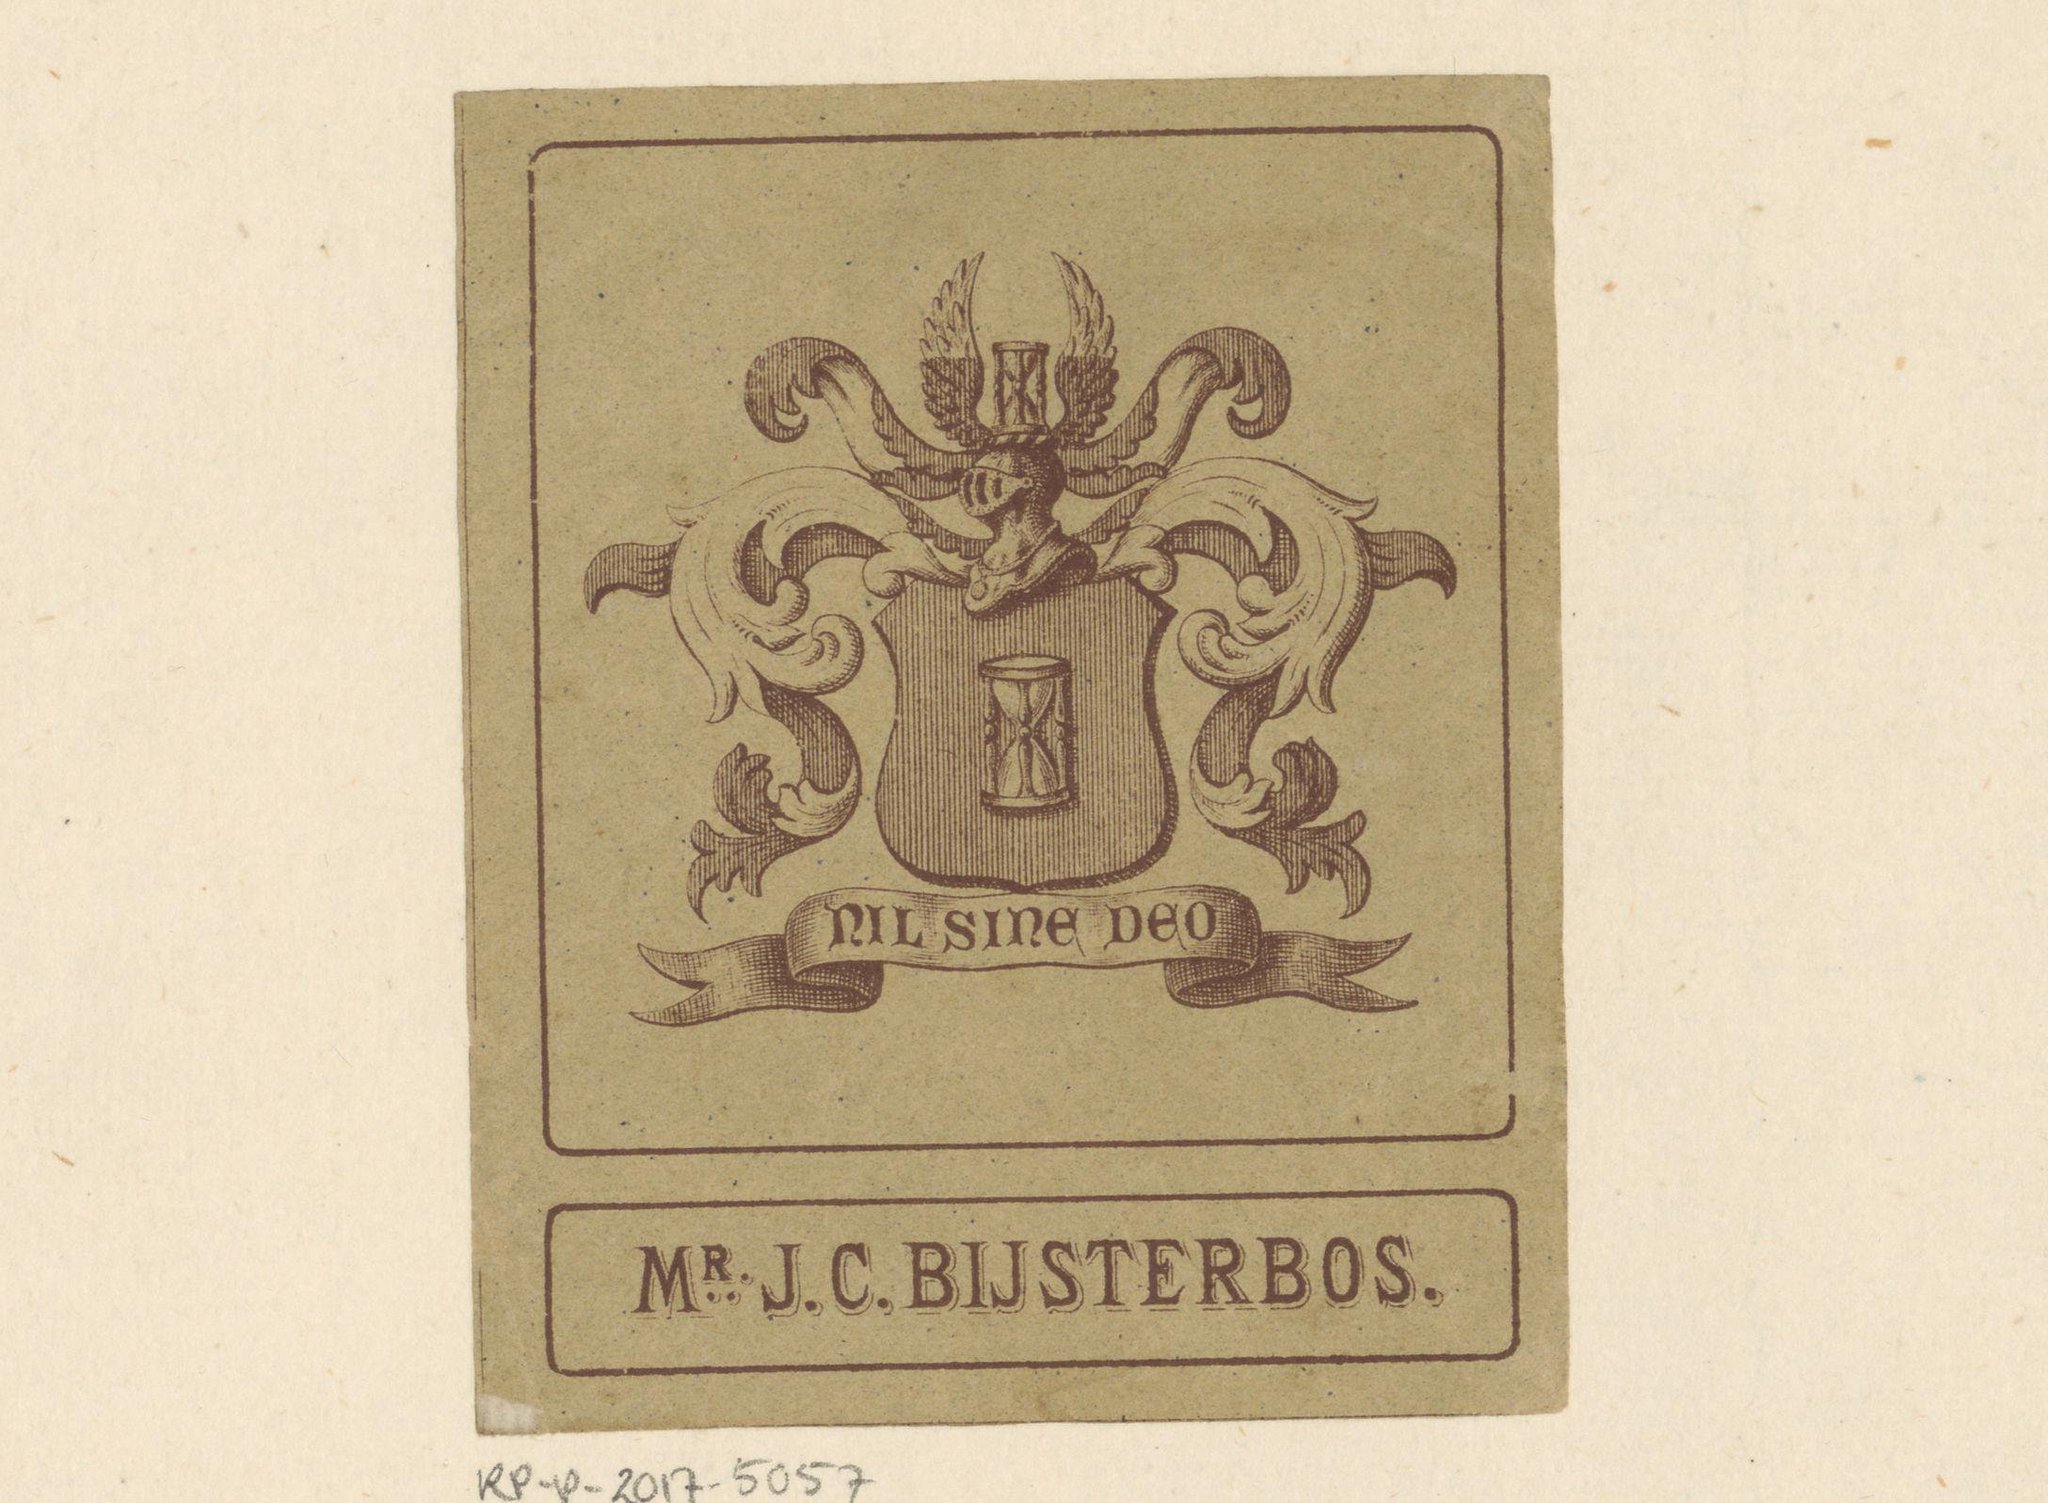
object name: bookplate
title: Nil sie Deo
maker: Anonymous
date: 1850-1898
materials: paper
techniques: printing block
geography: netherlands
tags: hourglass, armorial bearing, heraldry